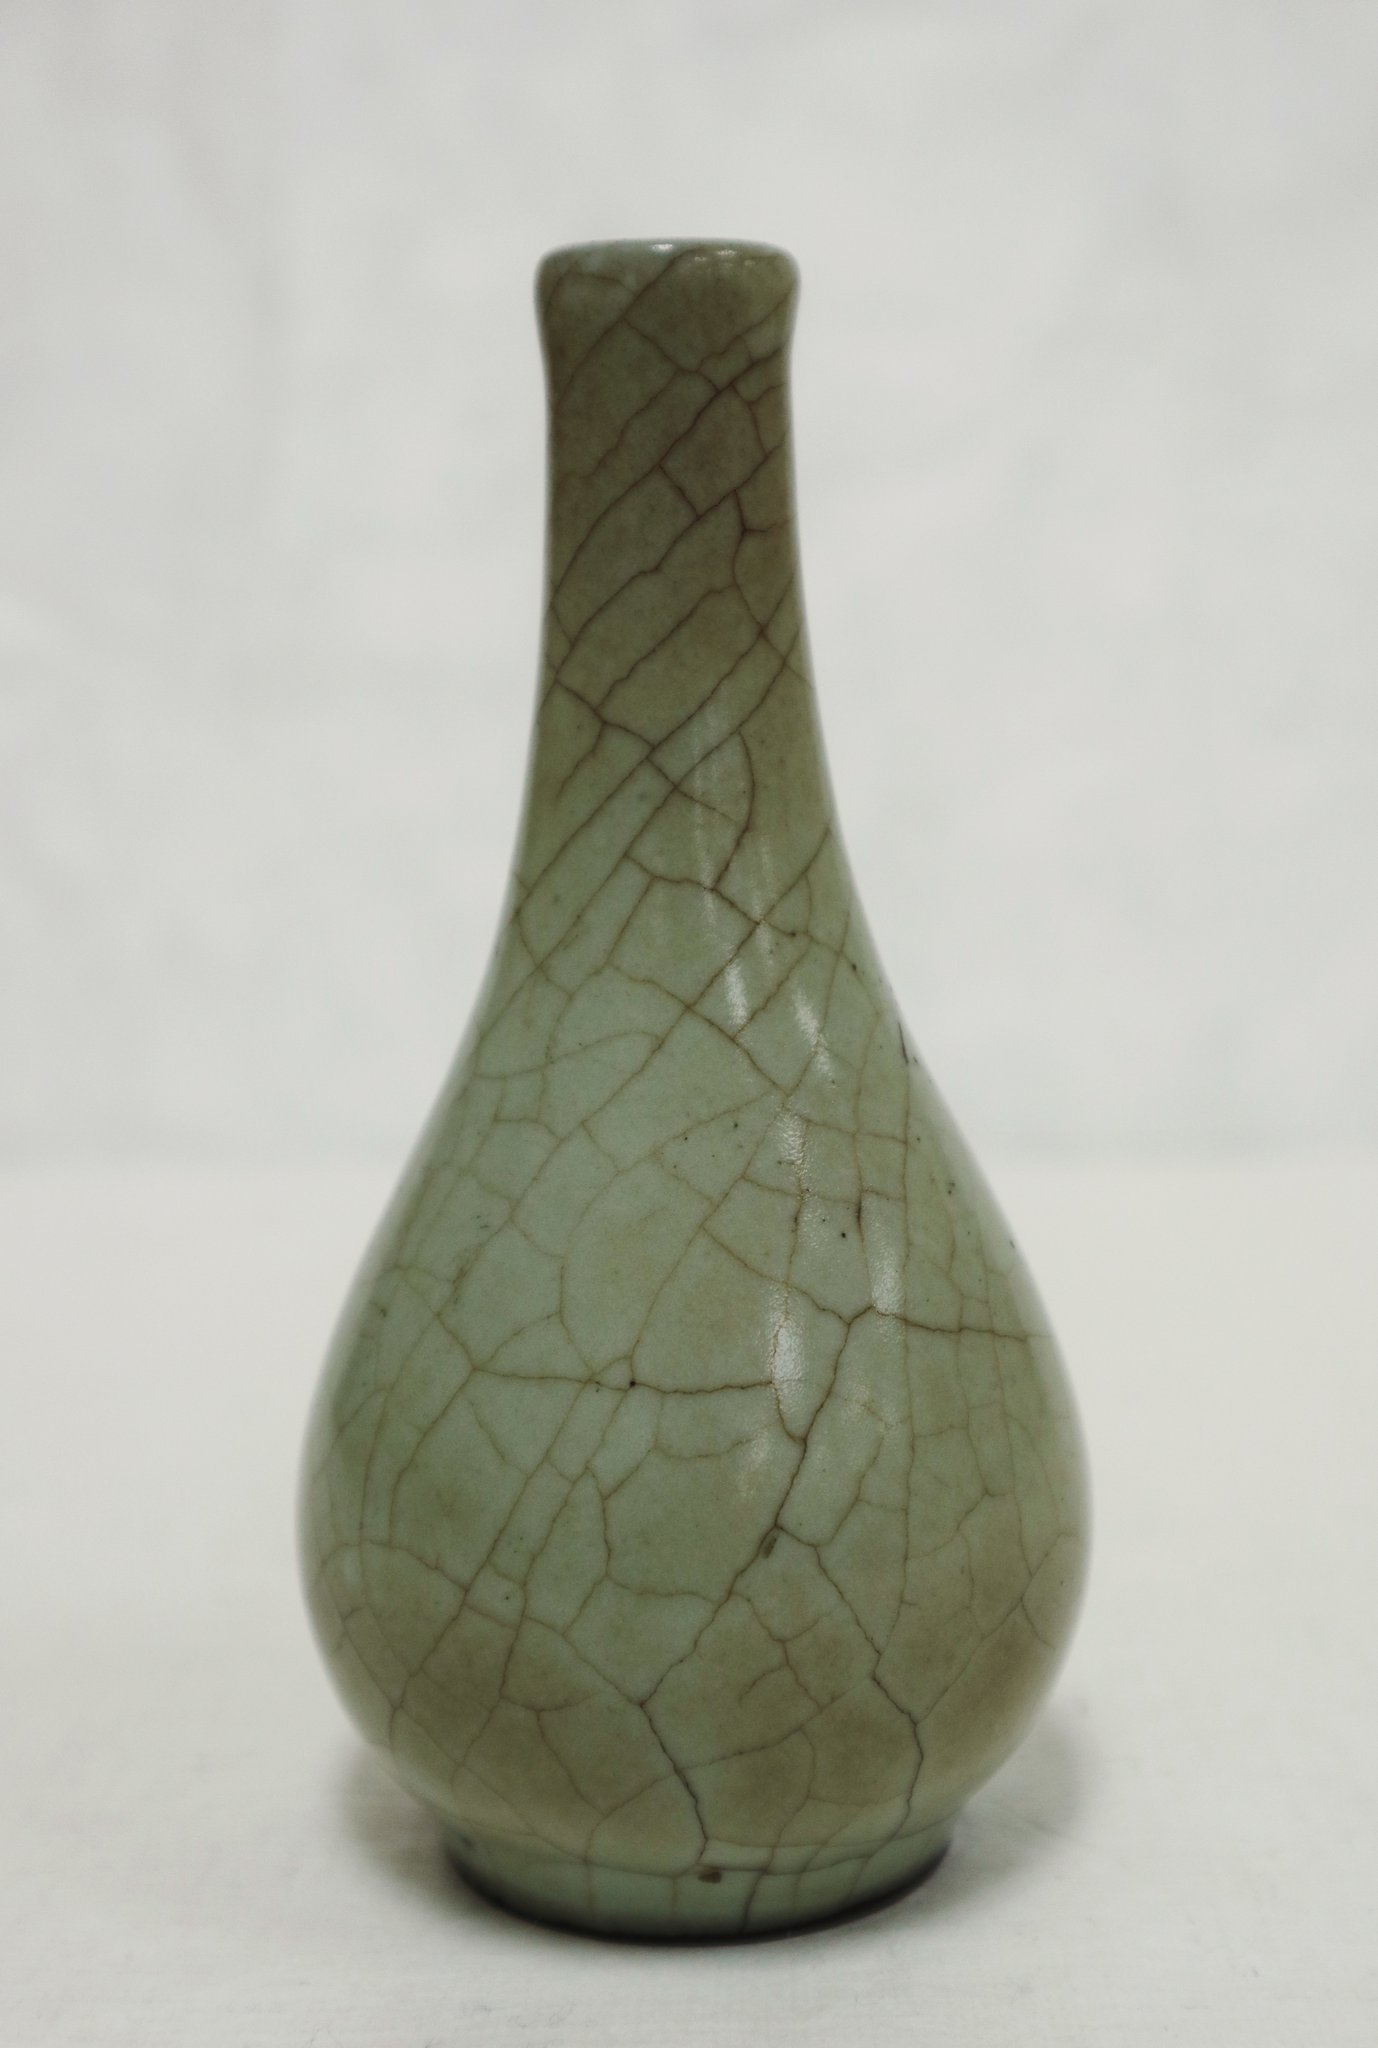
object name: vase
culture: chinese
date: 960-1279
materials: stoneware